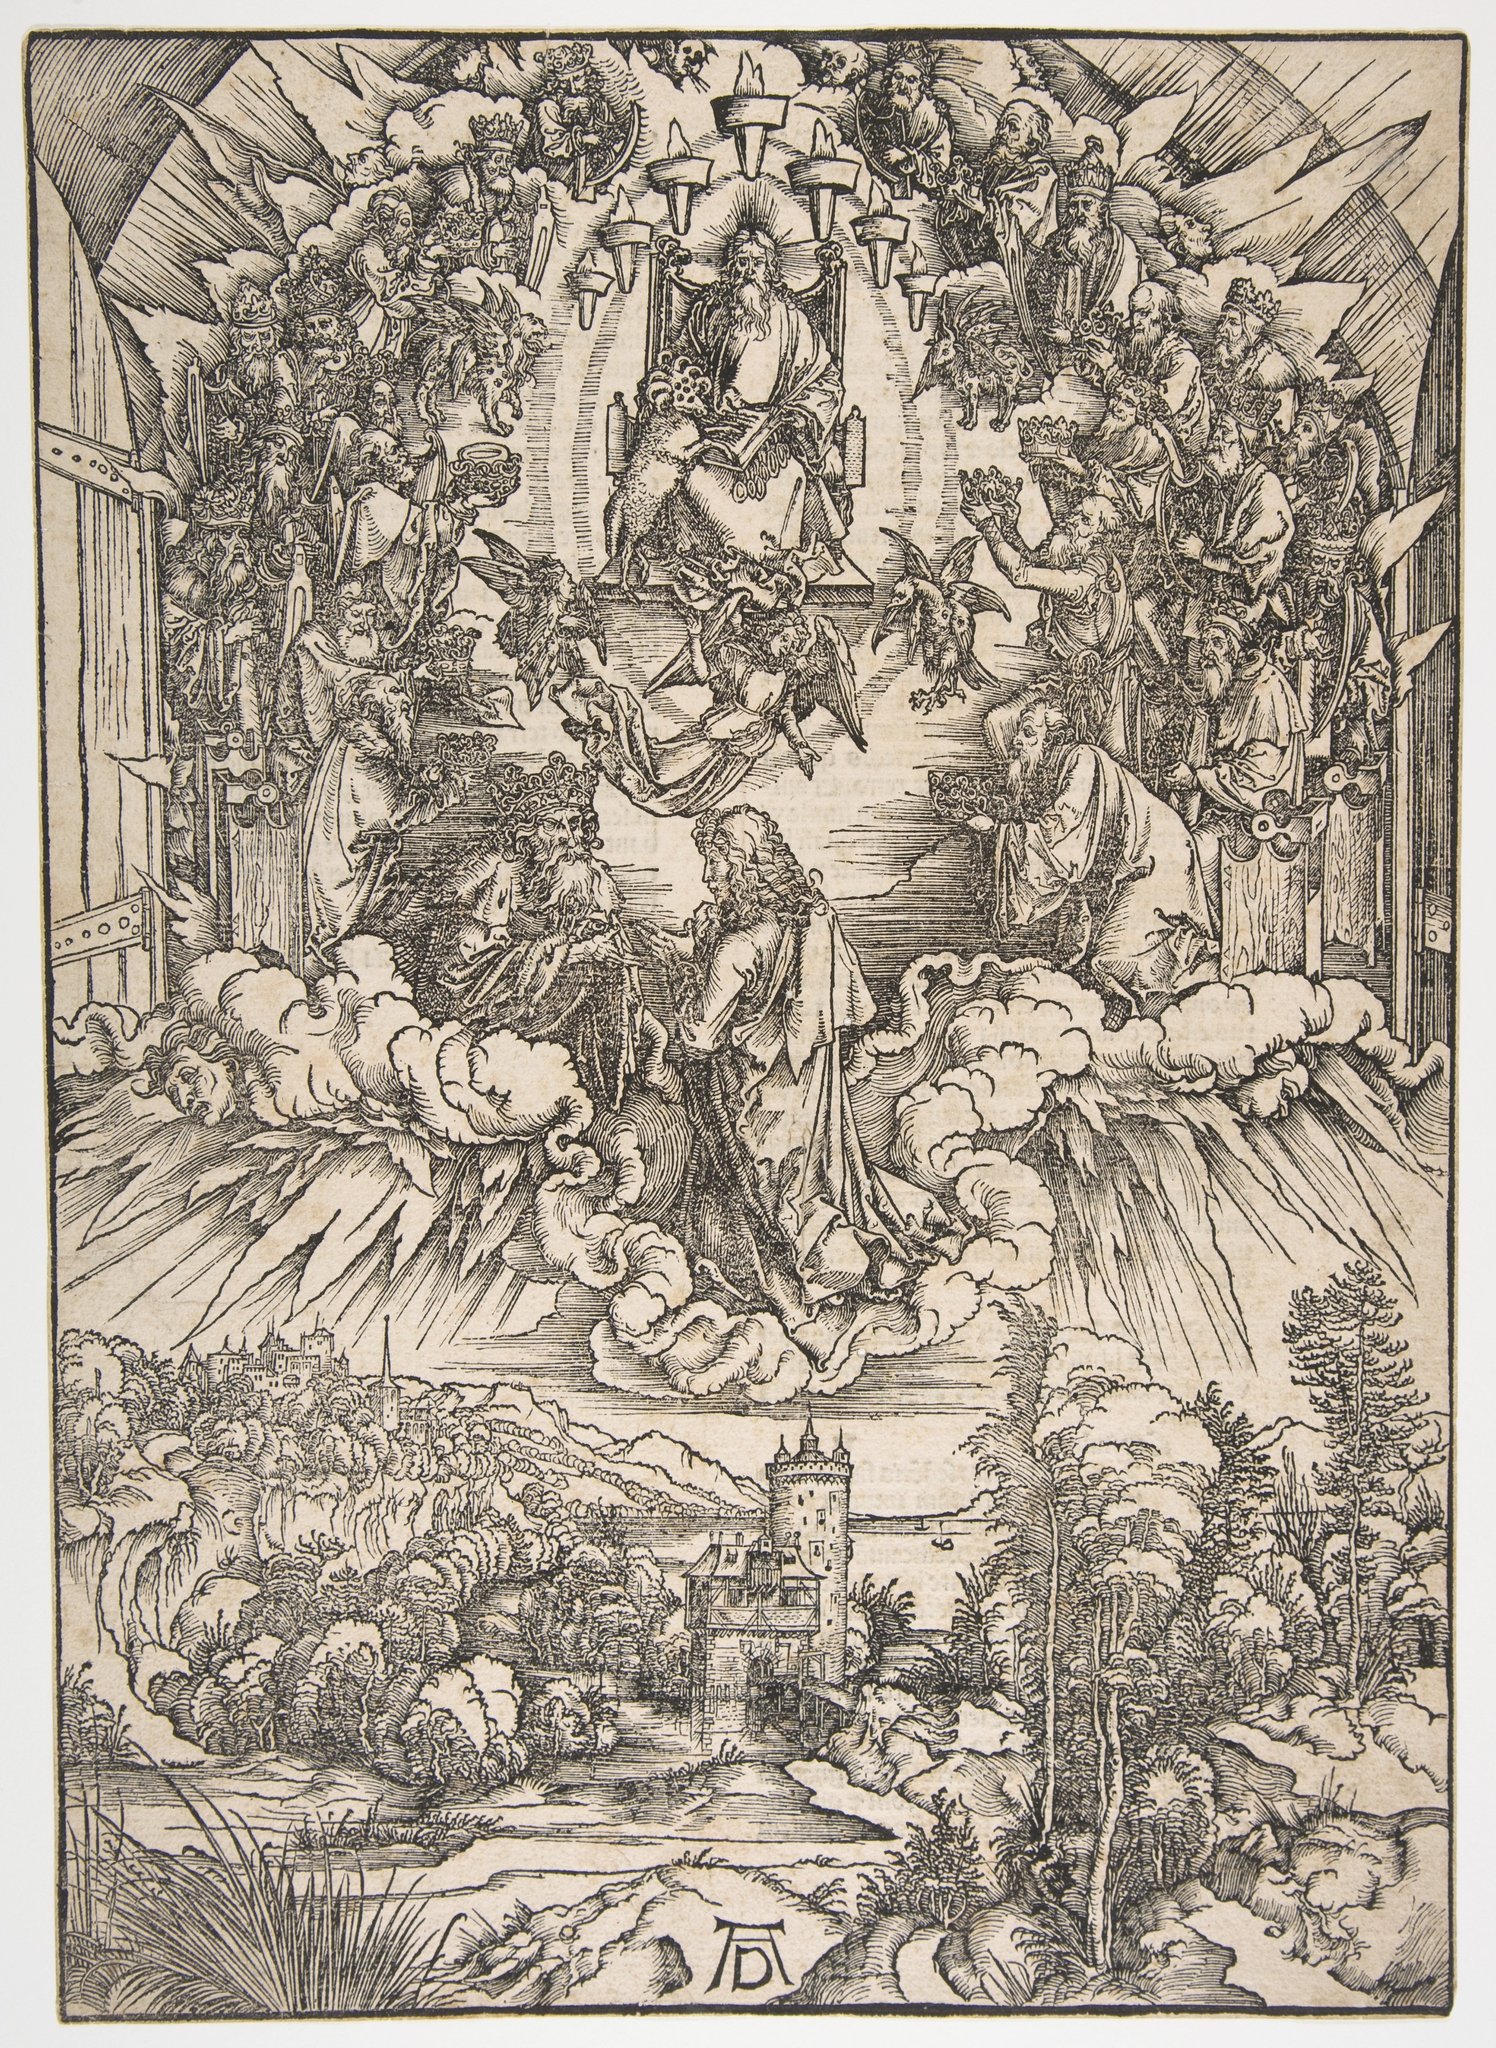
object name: print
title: Saint John before God and the Elders, from The Apocalypse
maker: albrecht dürer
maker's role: artist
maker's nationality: german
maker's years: 1471-1528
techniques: woodcut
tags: angels,apocalypse,saints,god the father